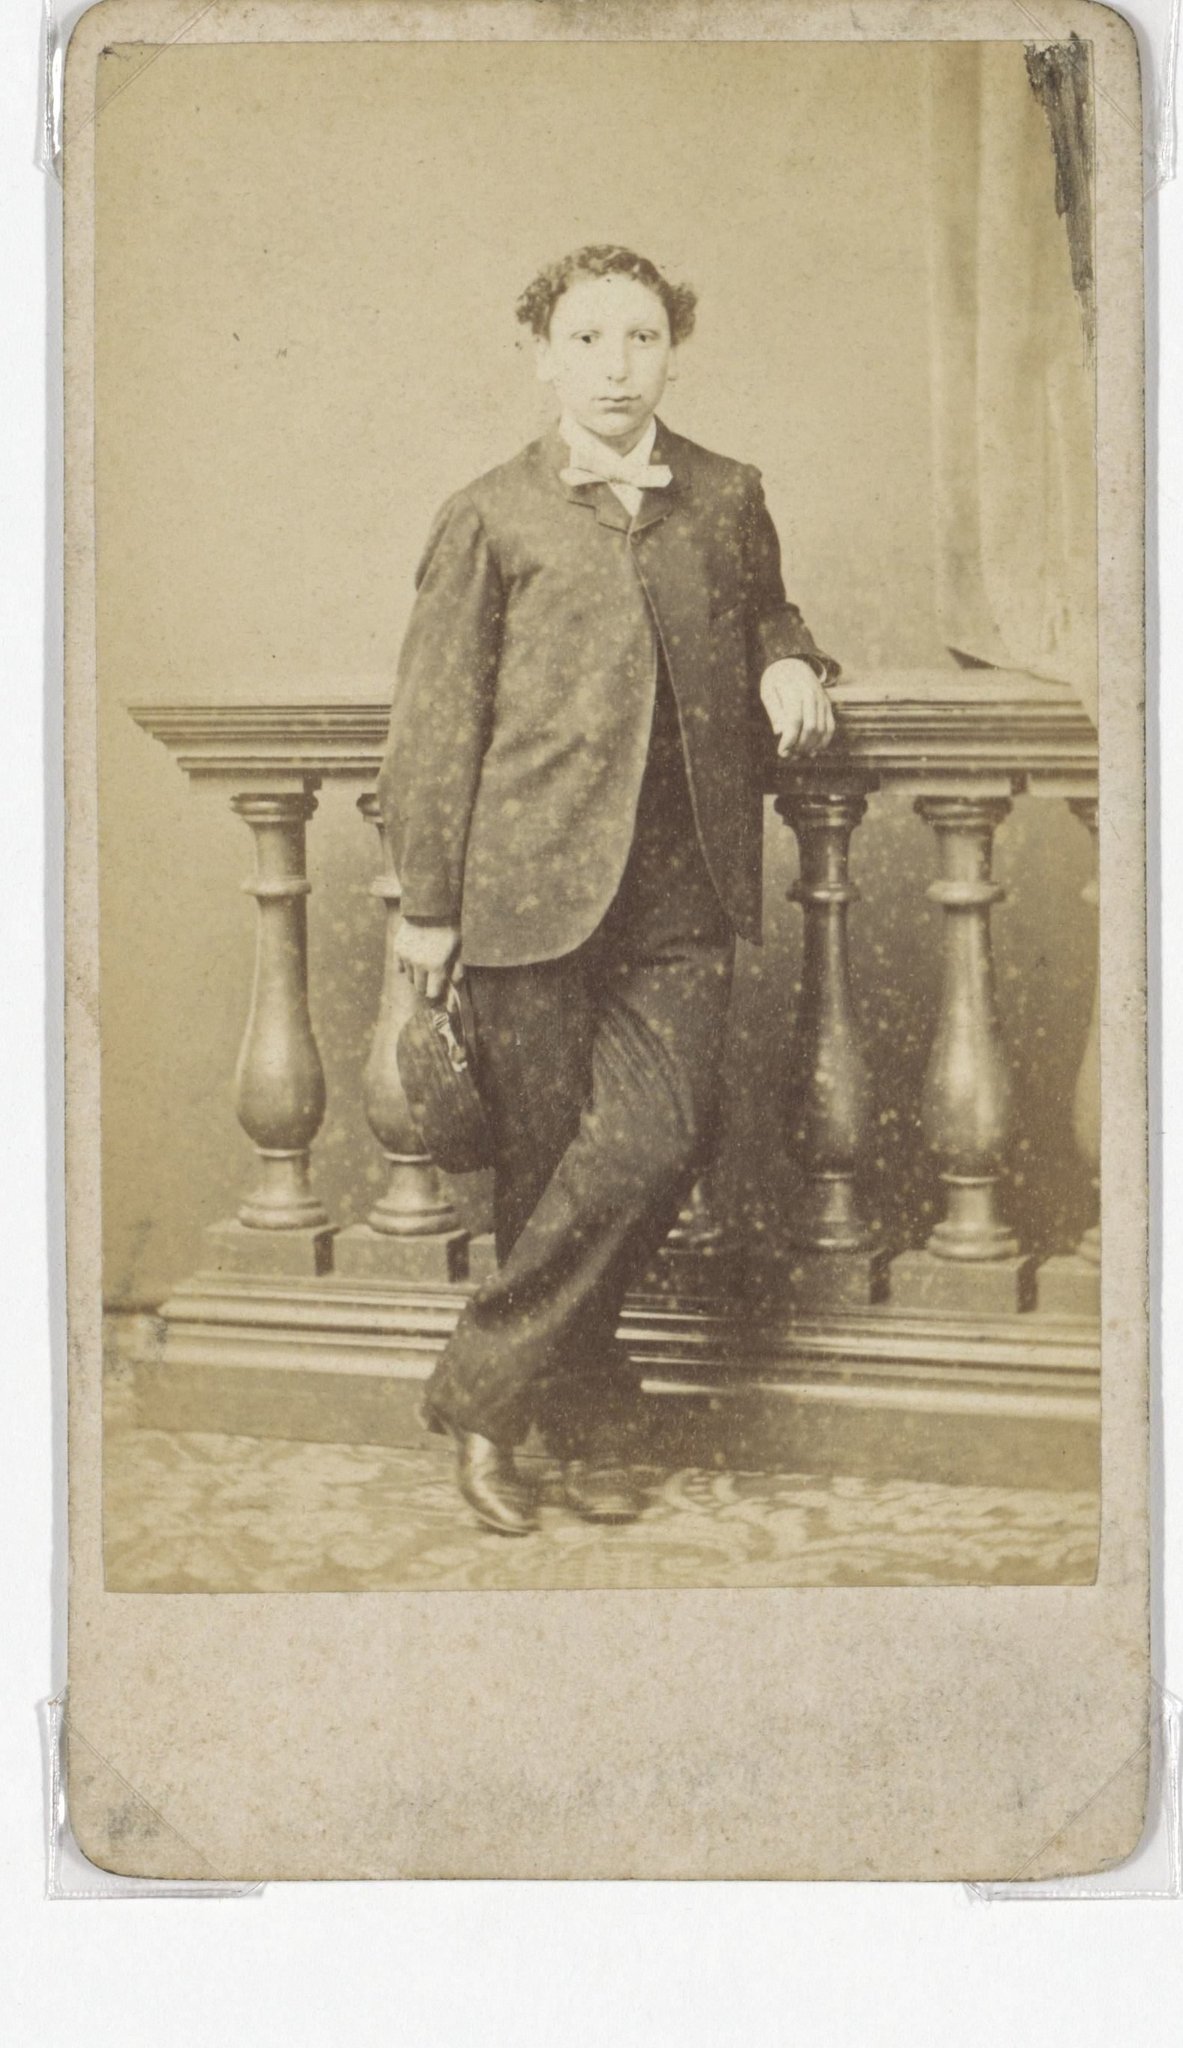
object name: photograph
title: Portret van een staande jongeman met een pet in de hand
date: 1870-1890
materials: cardboard, paper, photographic support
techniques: albumen print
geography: the hague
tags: studio requisites ~ photographer, historical persons not known by name, the hague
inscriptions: address: ‘'s Hage Gortstraat & Koningstraat’